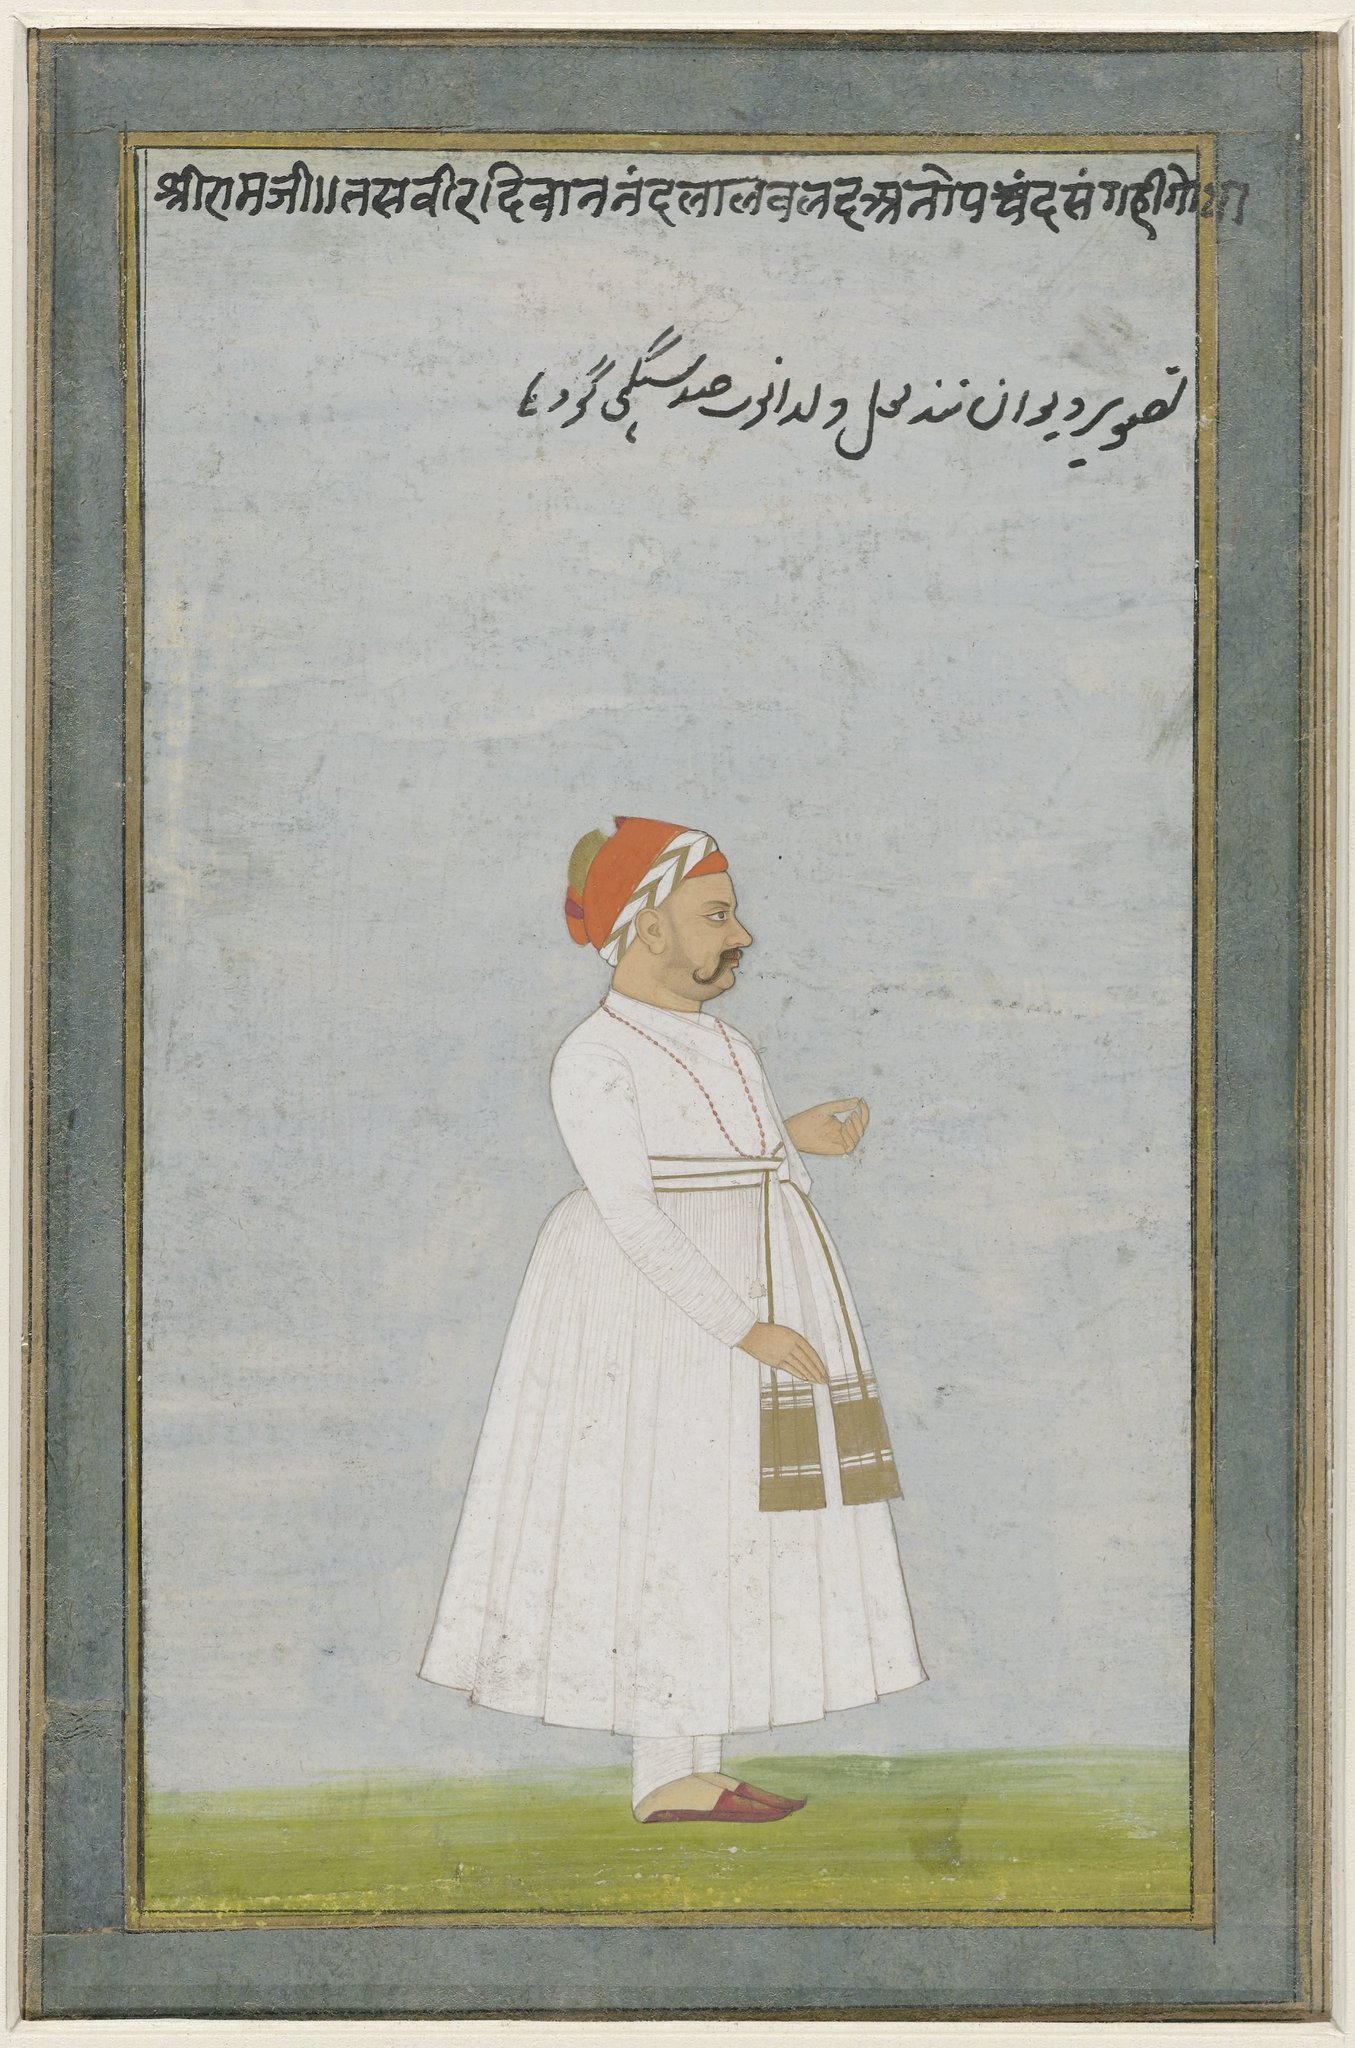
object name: indian miniature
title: Portret van een Jaipur functionaris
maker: Anonymous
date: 1835-1880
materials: cardboard, paint, gouache, paper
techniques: brush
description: Portret van een Jaipur functionaris, een dikke man in een wit gewaad, tegen een lichtblauwe en groene achtergrond.